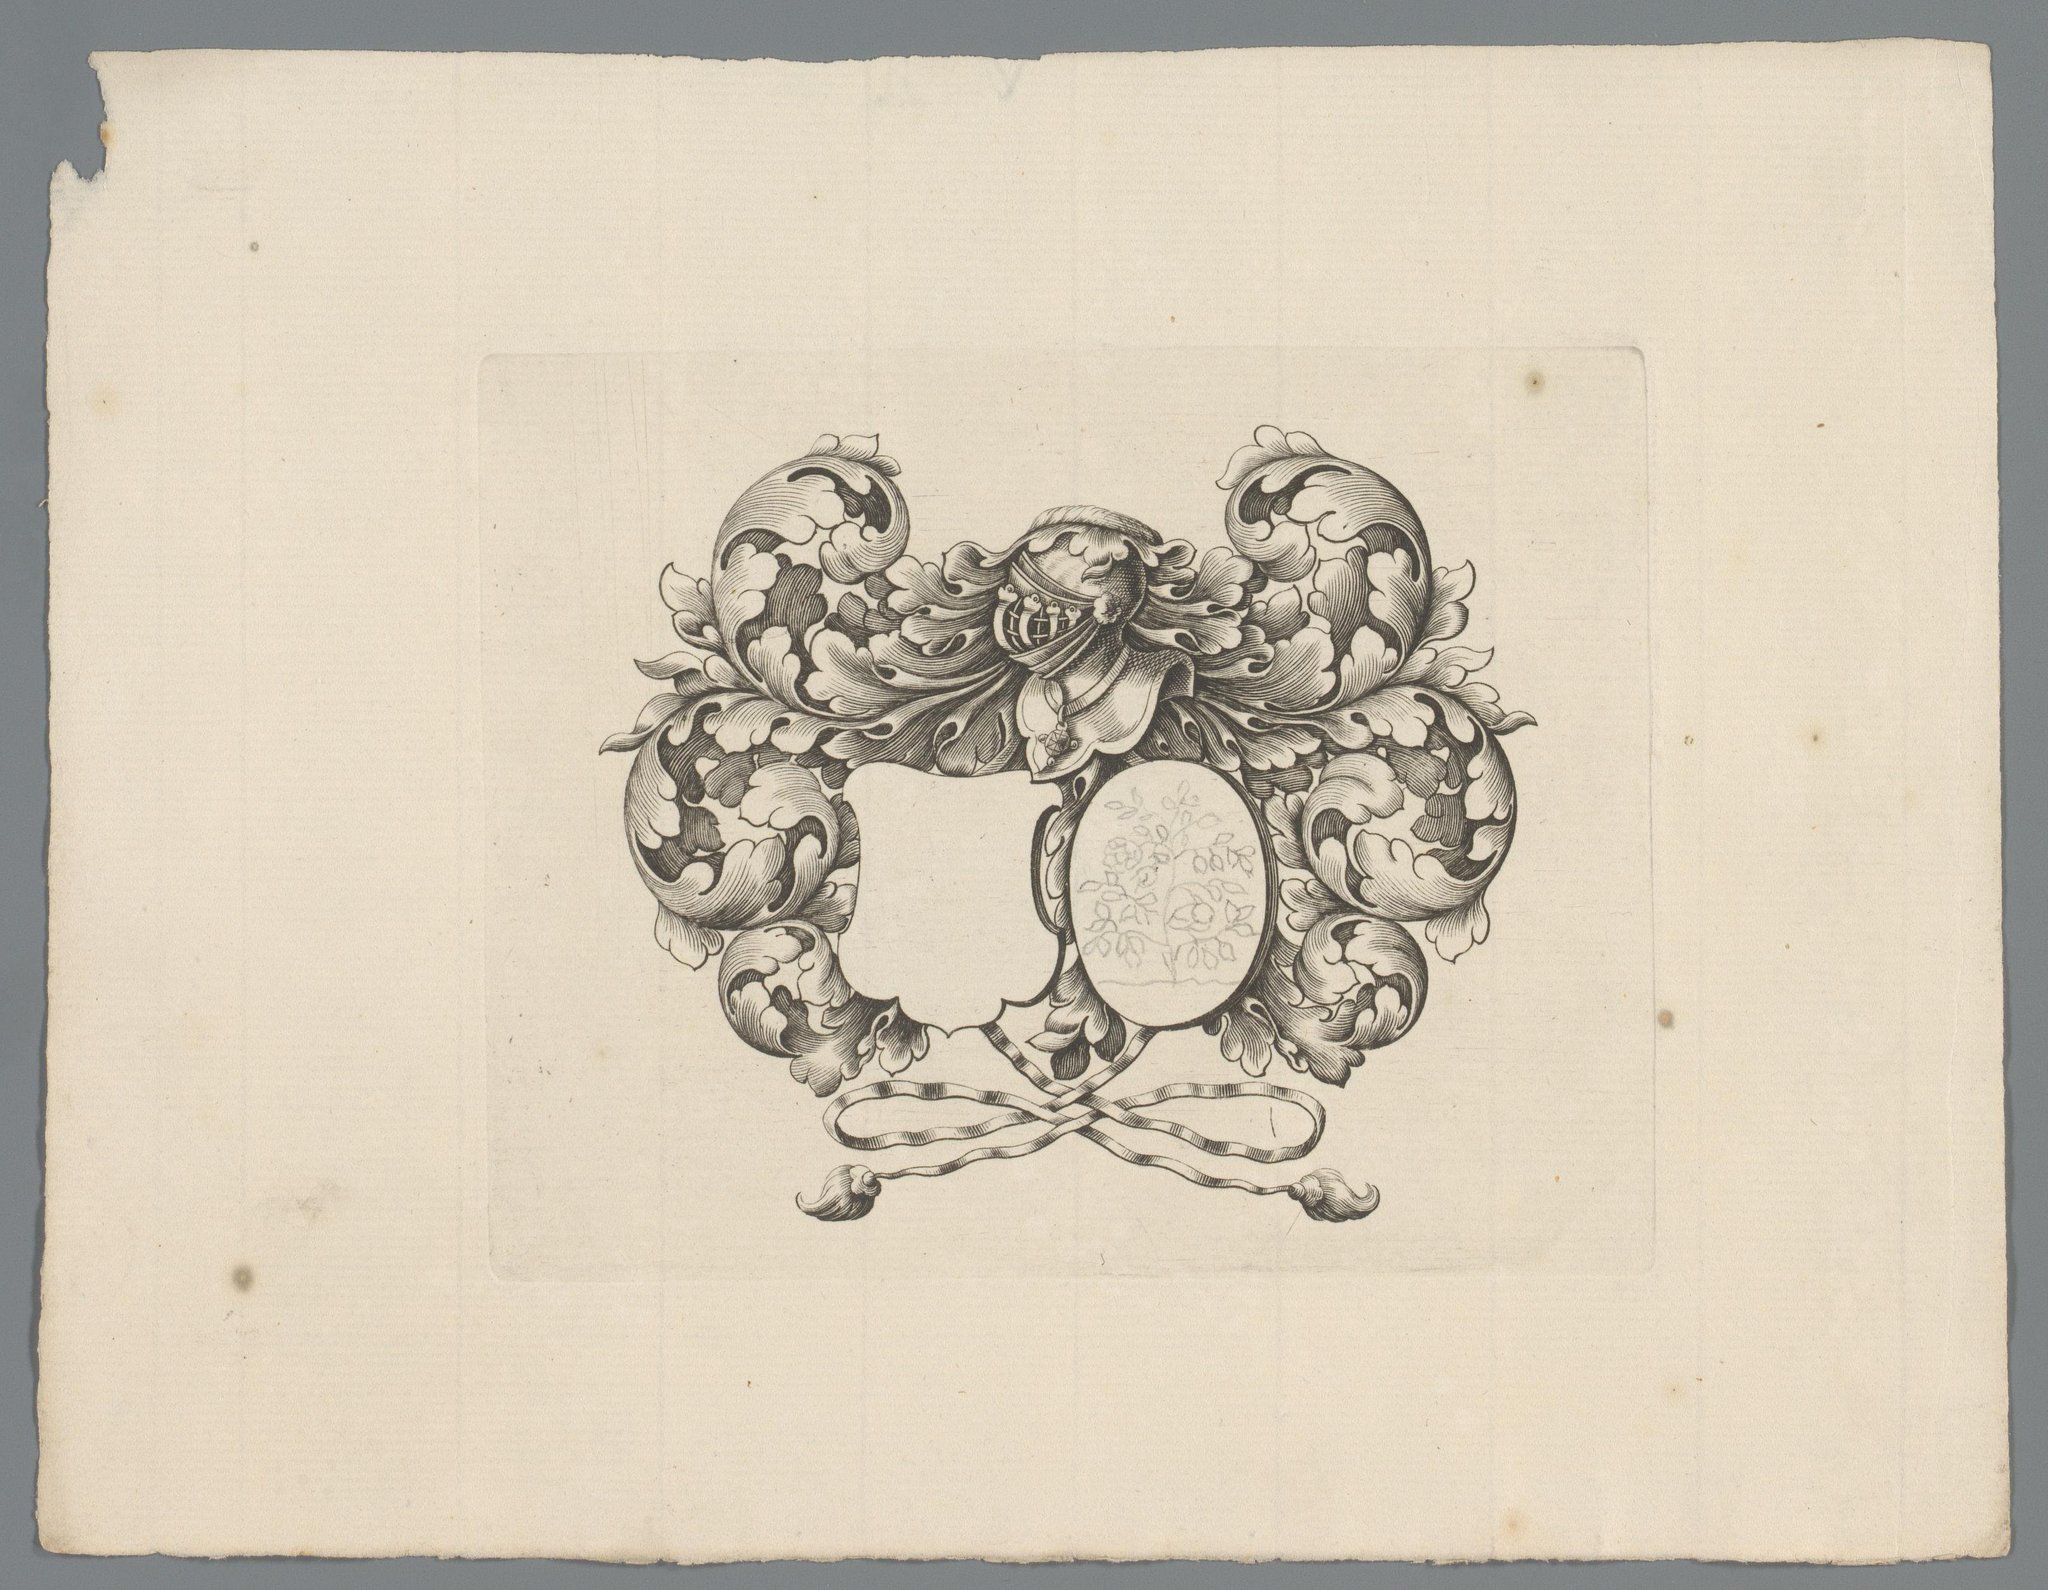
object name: print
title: Twee lege wapenschilden bekroond met een helm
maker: Anonymous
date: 1600-1699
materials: paper, pencil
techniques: engraving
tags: armorial bearing, heraldry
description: Getekend in het rechter wapenschild is een plant.